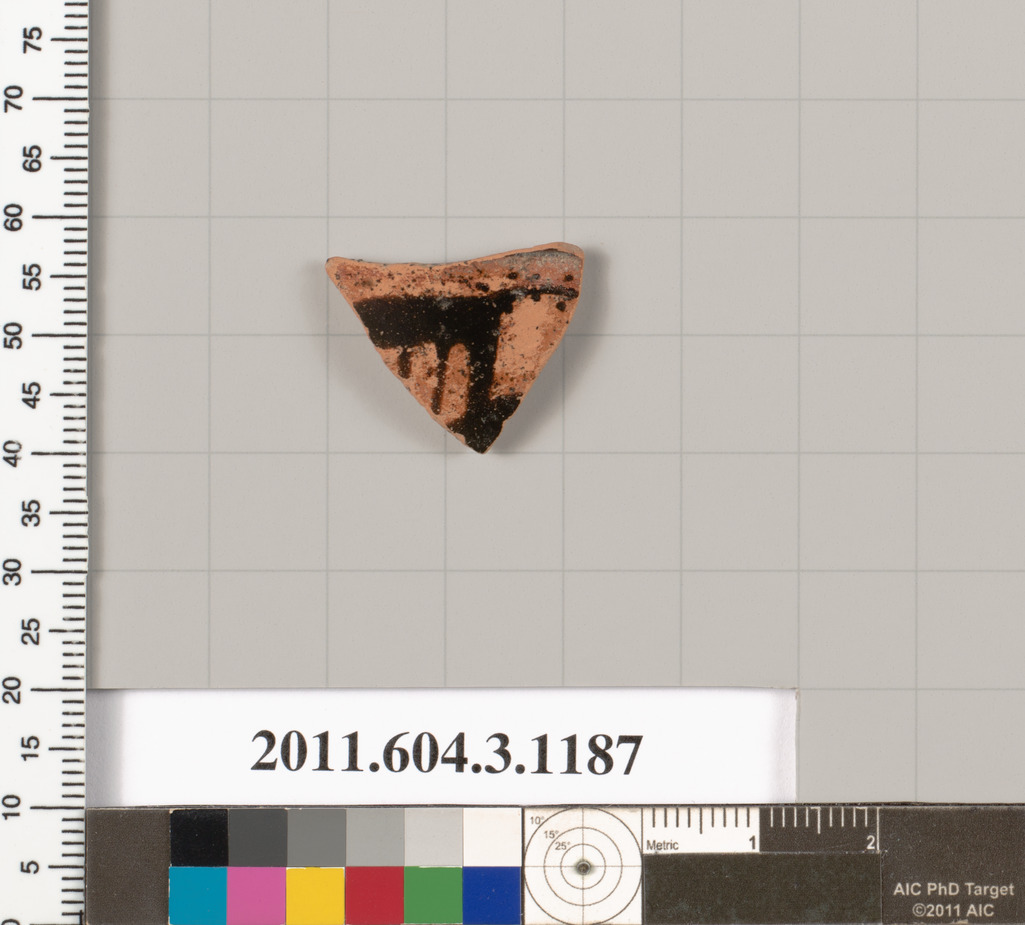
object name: mastoid fragment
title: Terracotta fragment of a mastoid (drinking cup with narrow base)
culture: greek, attic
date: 534-468 BCE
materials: terracotta